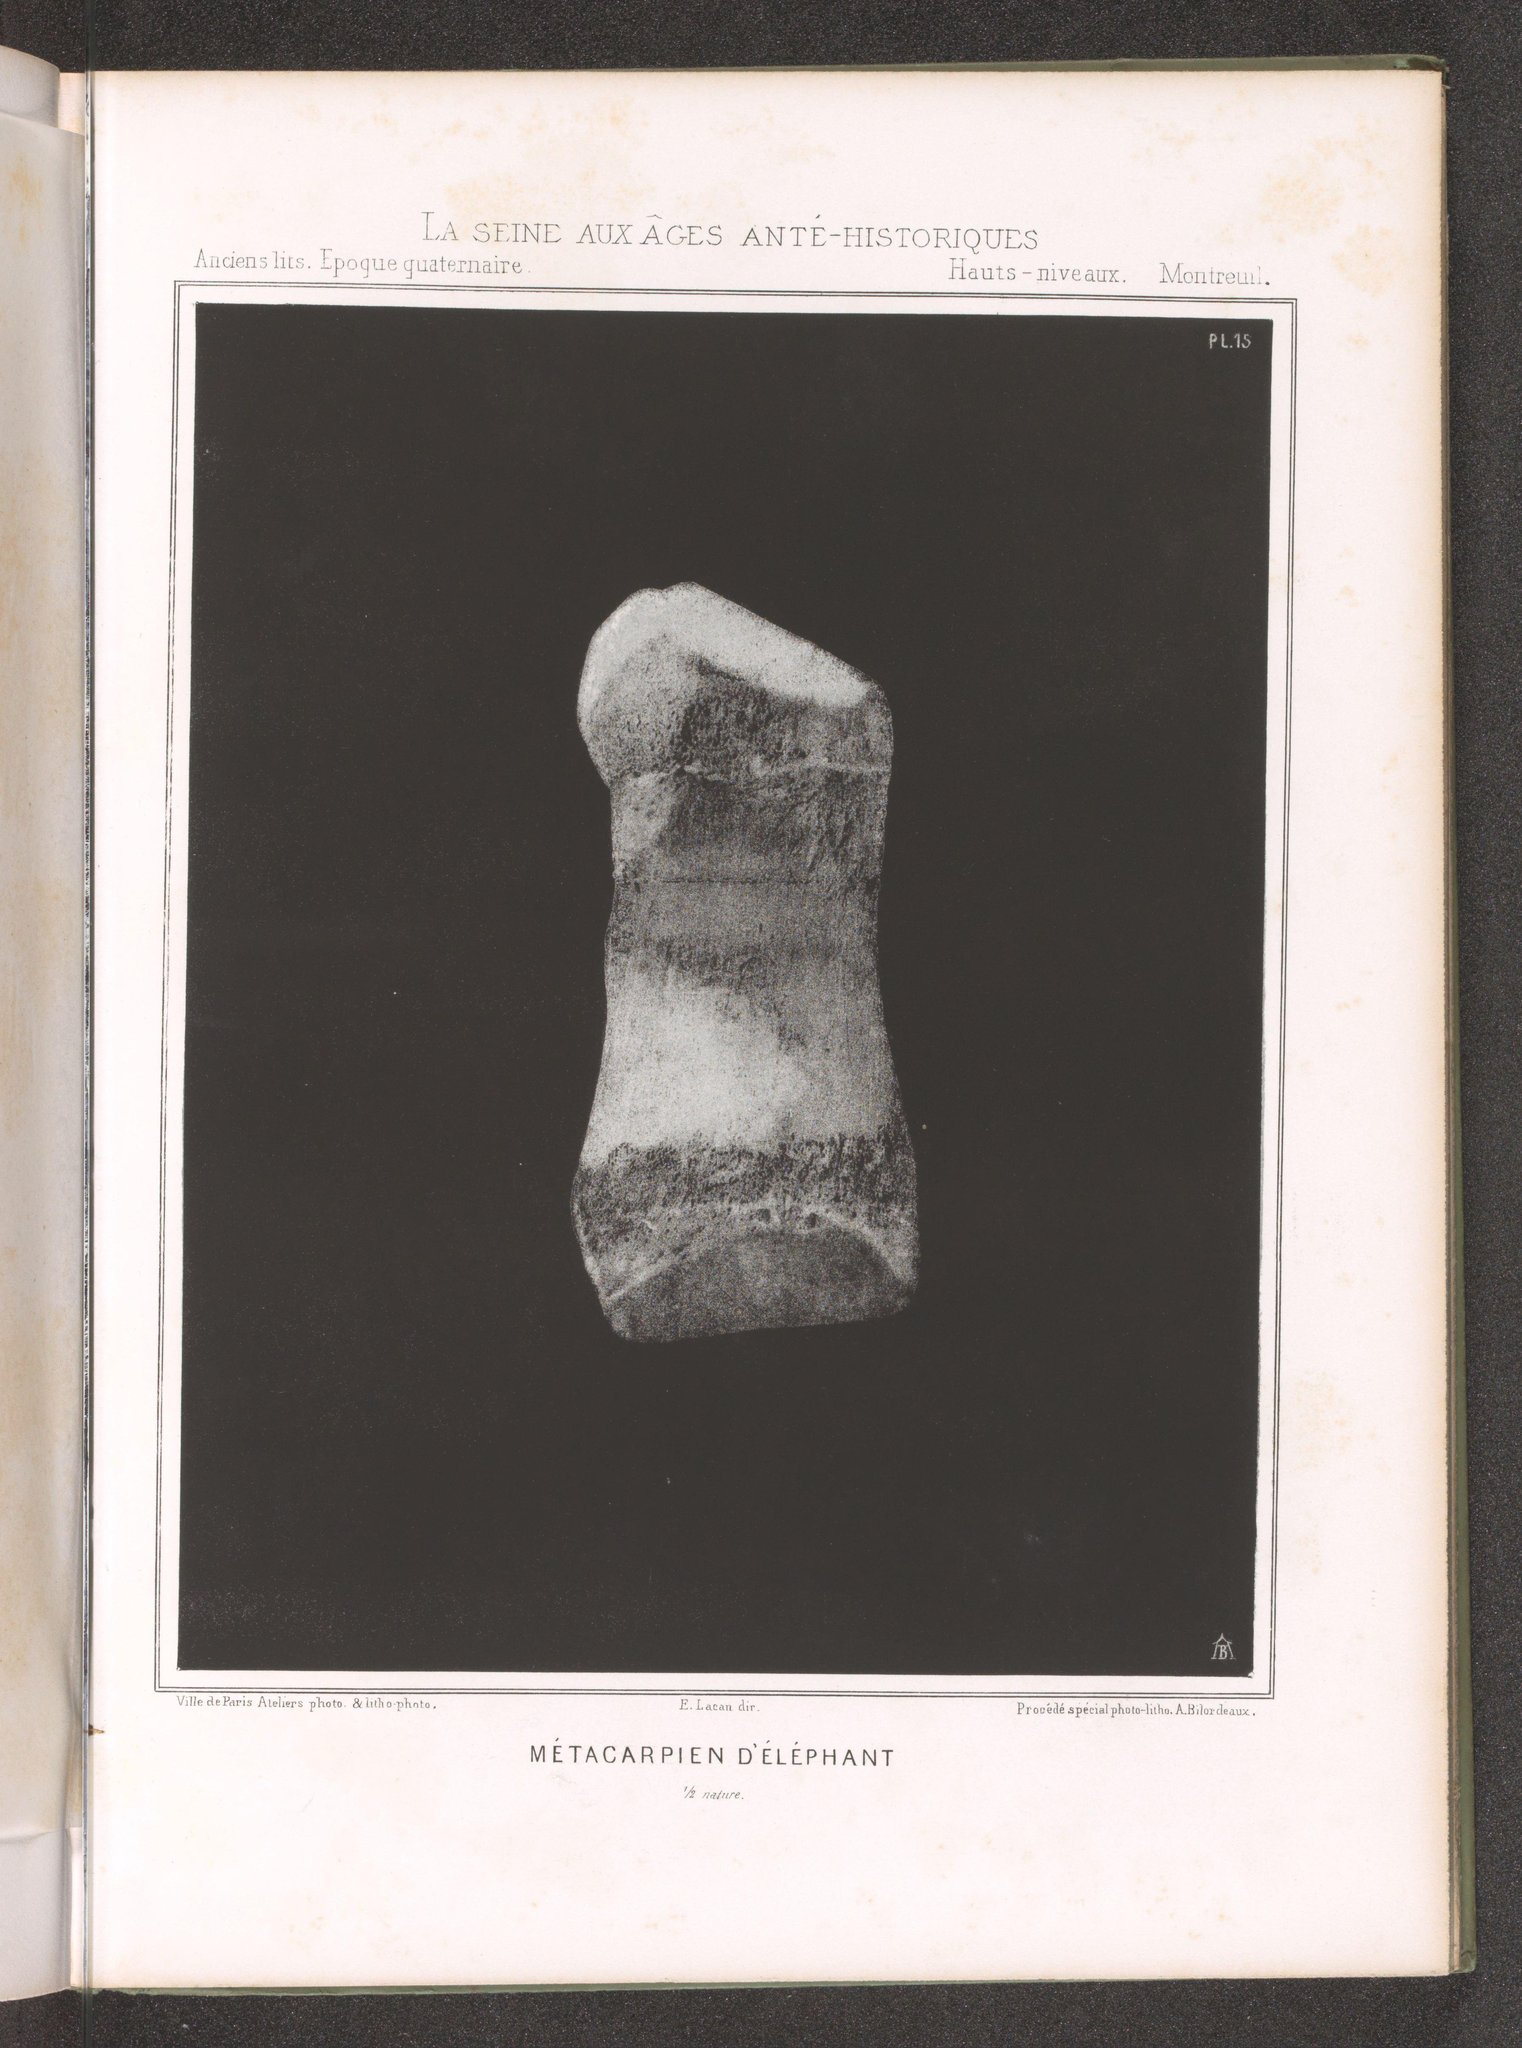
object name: page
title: Middenvoetsbeen van een olifant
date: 1860-1869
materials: paper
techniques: photolithography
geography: paris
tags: animals (+ skeleton of an animal), palaeontology, france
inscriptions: monogram: ‘AB’, number: ‘Pl. 15’, inscription: ‘Ville de Paris Ateliers photo & litho-photo. E. Lacan, dir. Procédé spécial photo-litho A. Bilordeaux’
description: Voor plek prent in boek: zie nummer onder 'Opschriften / Merken'.